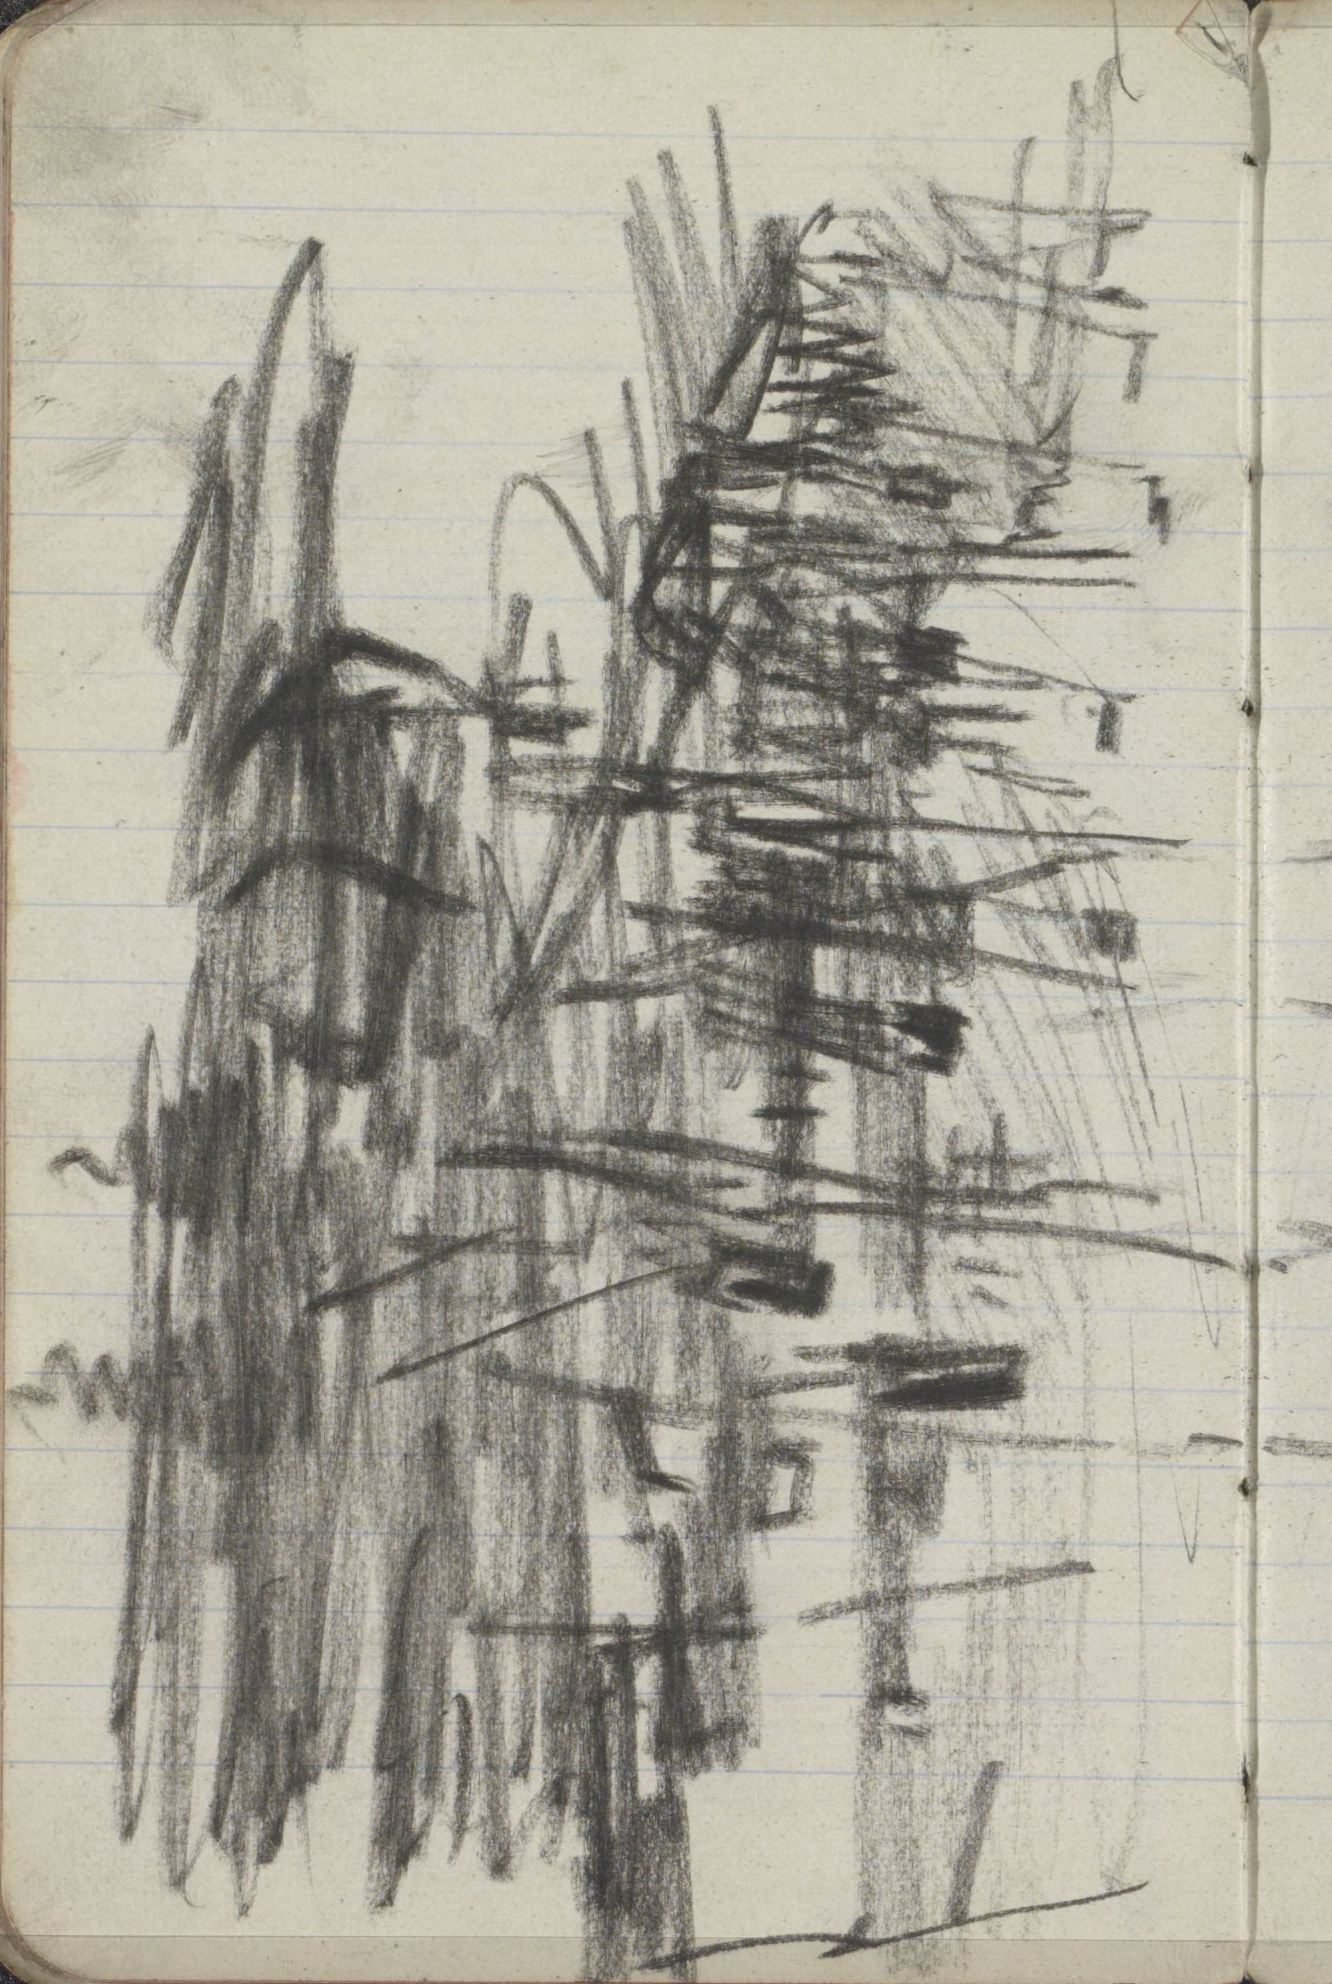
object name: sketchbook leaf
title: Aangemeerde boten in Amsterdam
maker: george hendrik breitner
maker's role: draughtsman, painter, print maker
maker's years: 1857-1923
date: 1893-1898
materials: chalk, paper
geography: amsterdam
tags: ships (in general), canals, waters (in city), amsterdam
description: Pagina 45 uit een schetsboek met 38 bladen.